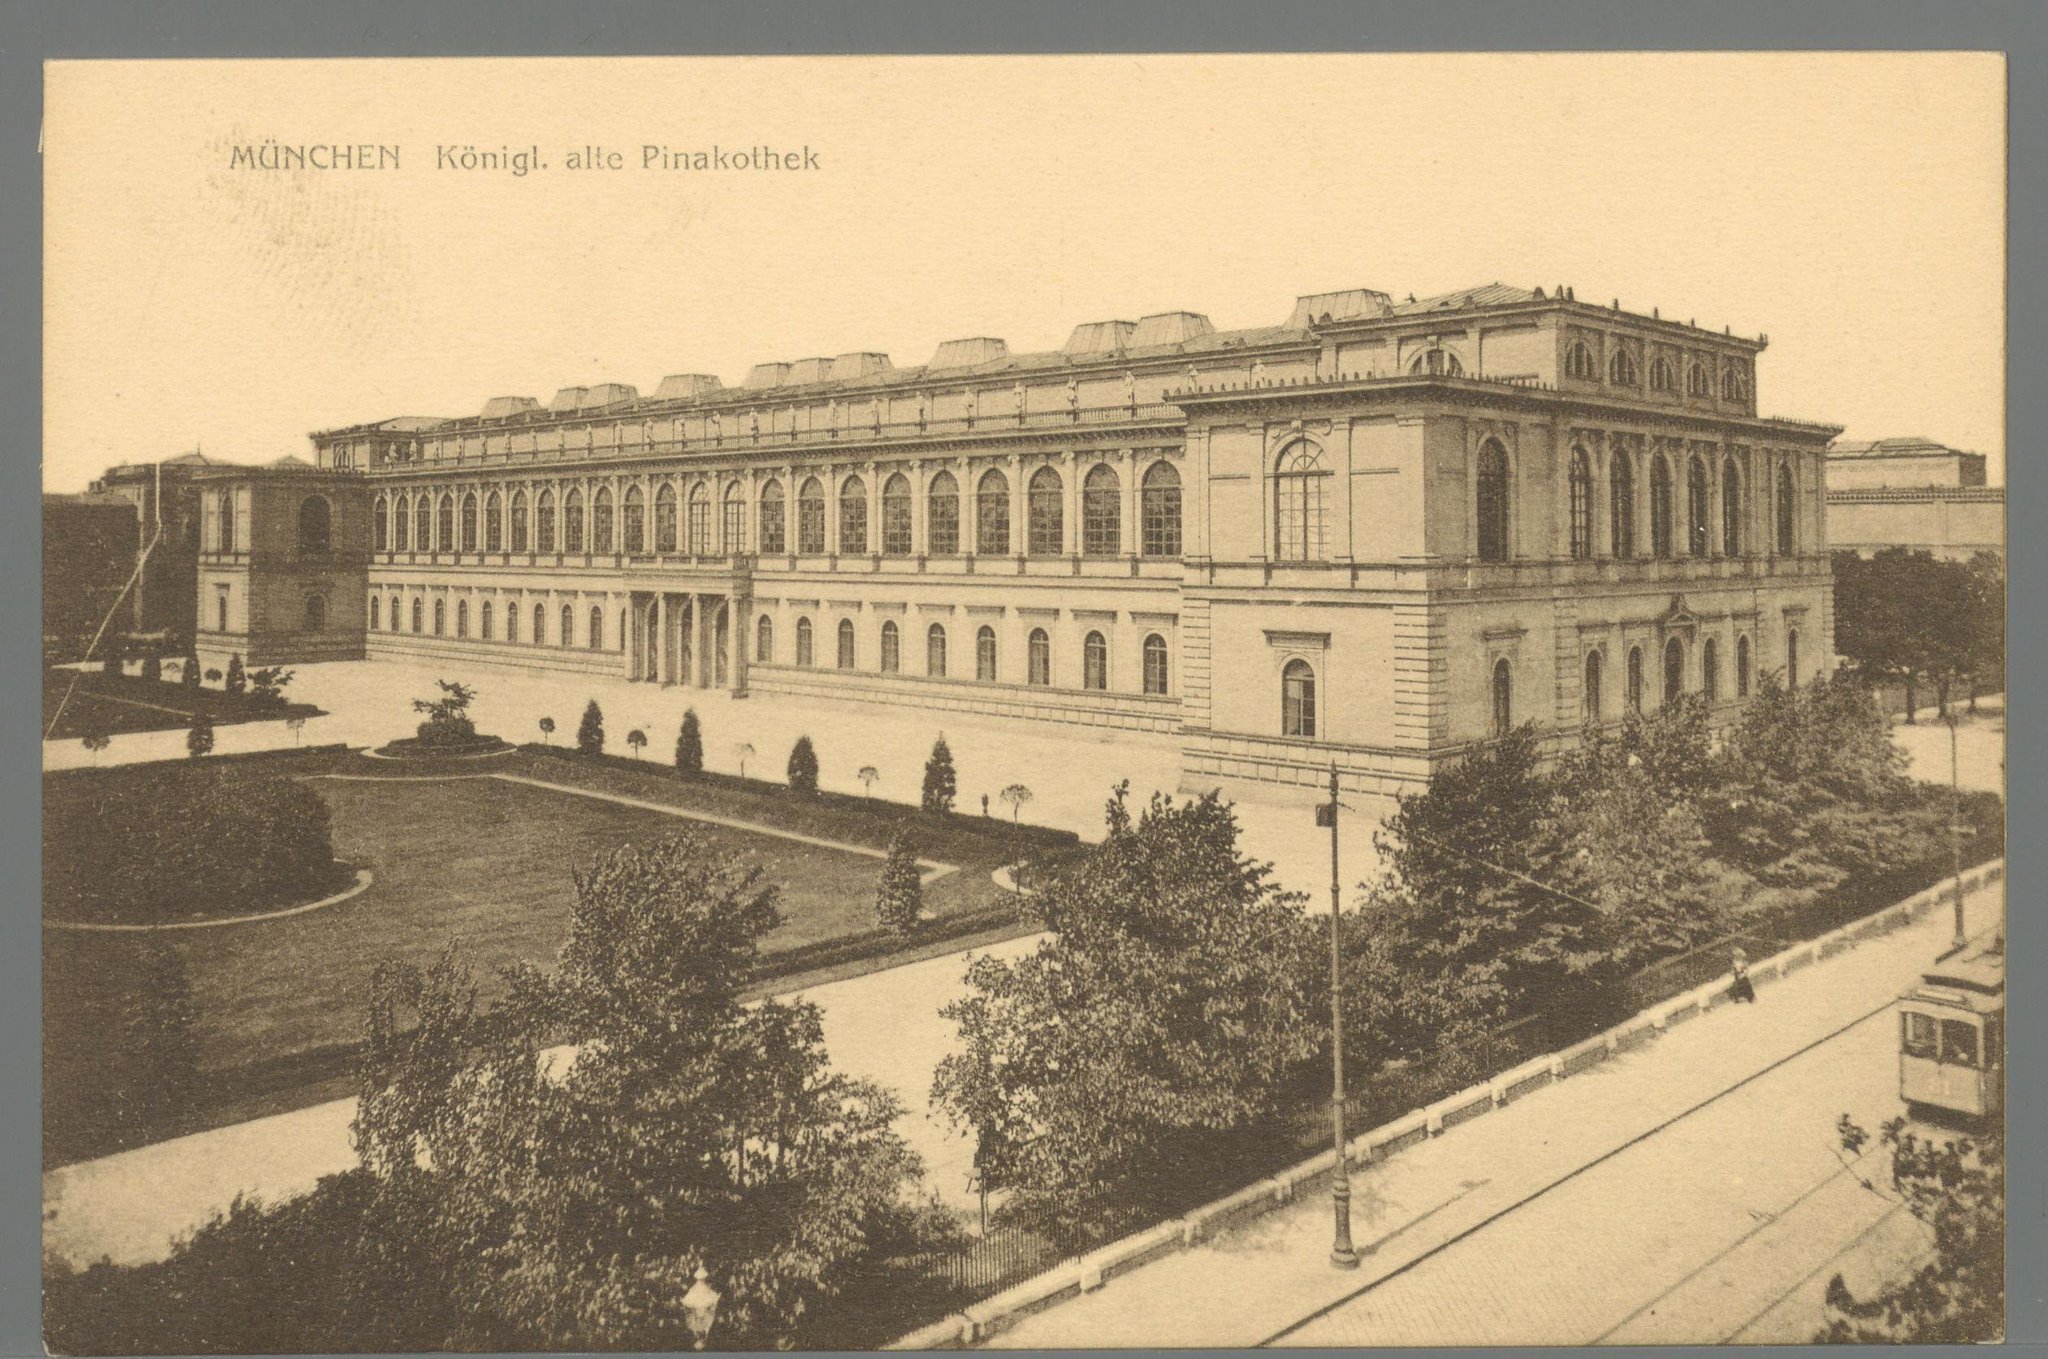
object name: photomechanical print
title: München. Königl. alte Pinakothek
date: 1905-1930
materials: cardboard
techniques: photograph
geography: munich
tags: permanent exhibition, museum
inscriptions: inscription: ‘W.H.D.’